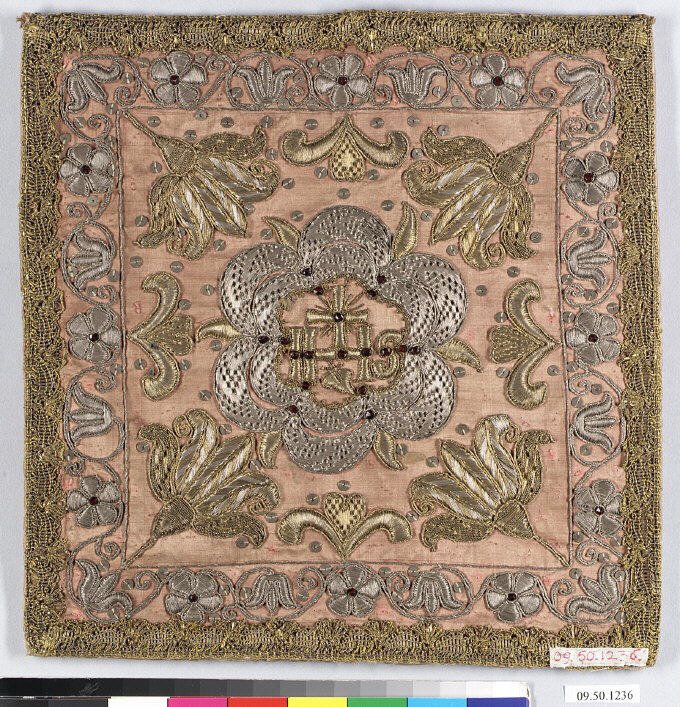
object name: chalice cover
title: Chalice Veil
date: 1701-1800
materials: metal thread, silk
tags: flowers